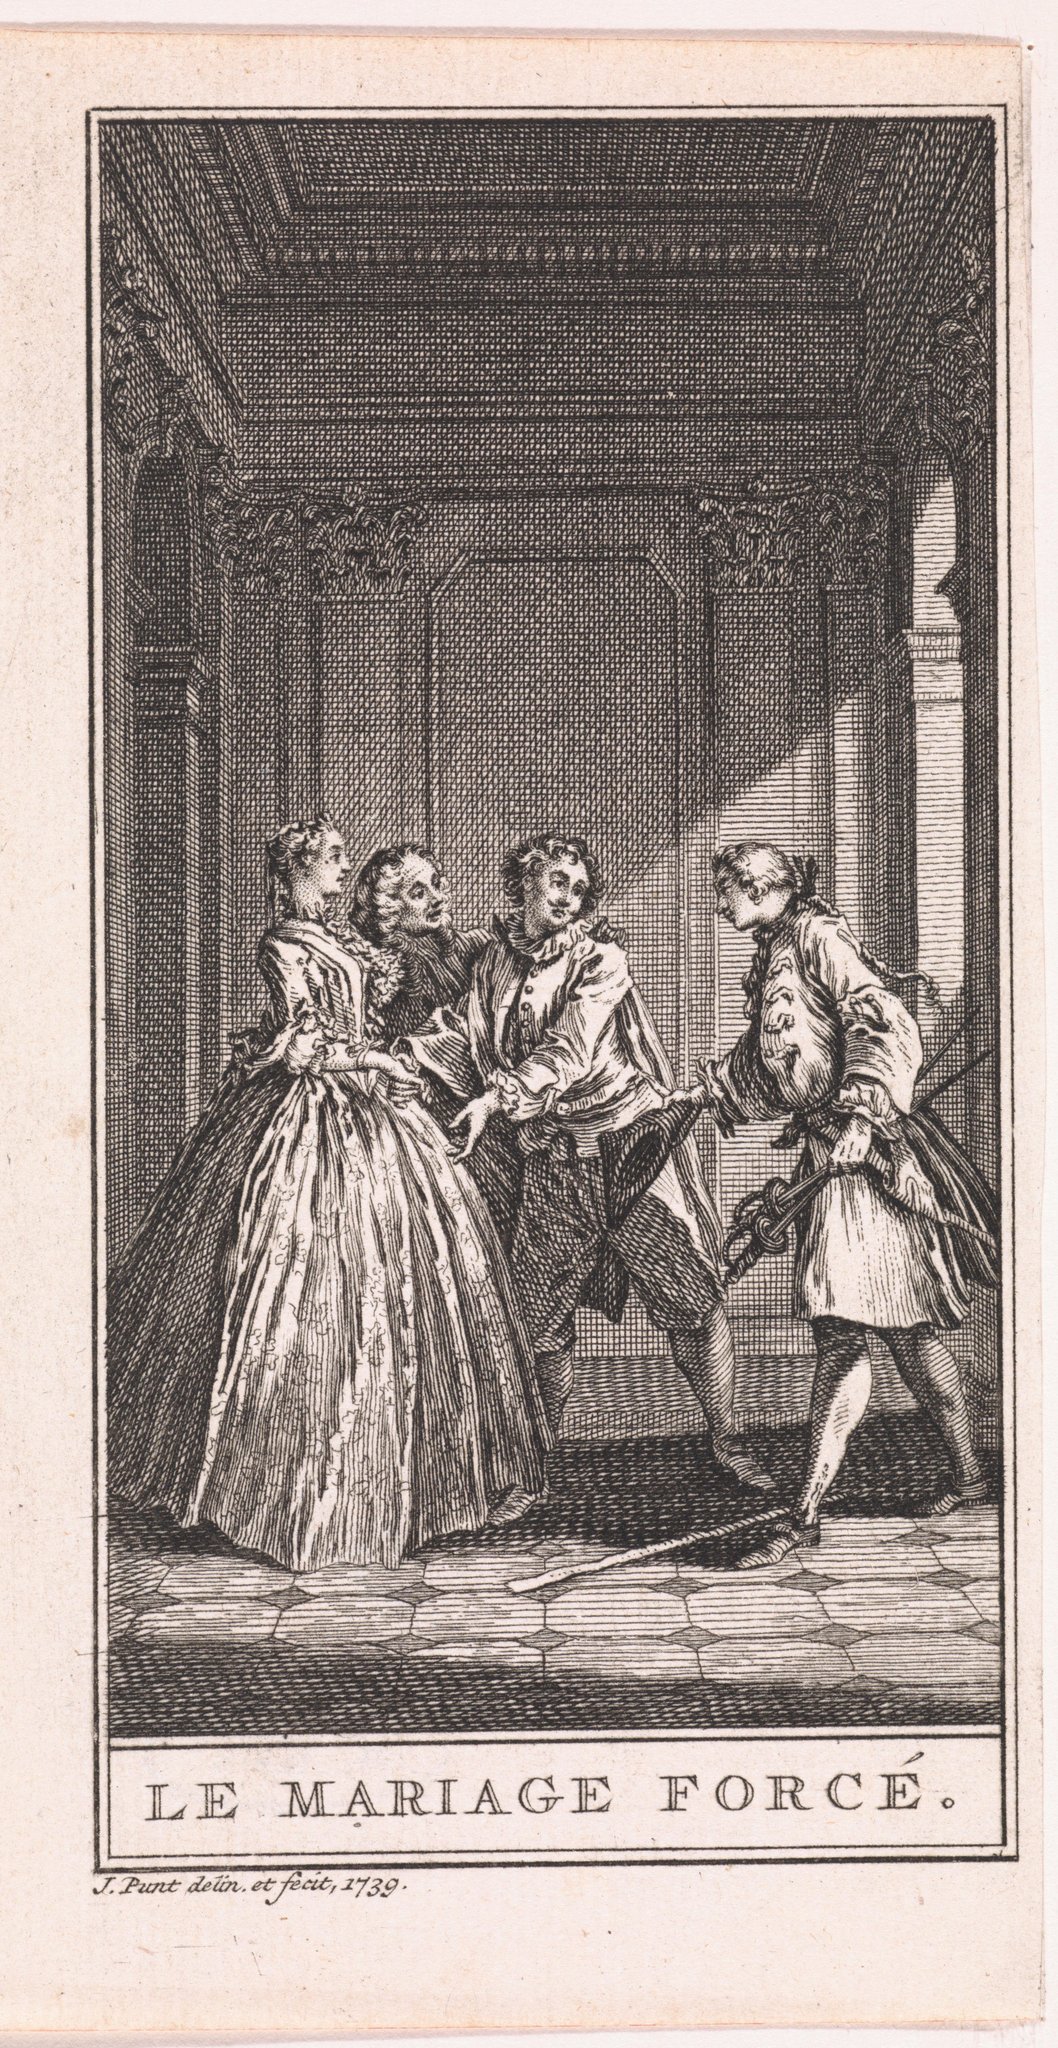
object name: book illustration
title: Vrouw wordt gepresenteerd aan man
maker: jan punt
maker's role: draughtsman, print maker, publisher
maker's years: 1711-1779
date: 1739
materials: paper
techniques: engraving, etching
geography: amsterdam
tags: (moliere) specific works of literature (with author, title), parental agreement ~ marriage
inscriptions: collector's mark: Lugt 2228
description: Prent gebruikt als illustratie in: Oeuvres de Molière, Nouvelle Edition, deel II, p. 140. Amsterdam en Leipzig: Johann Caspar Arkstee & Henricus Merkus, 1750.